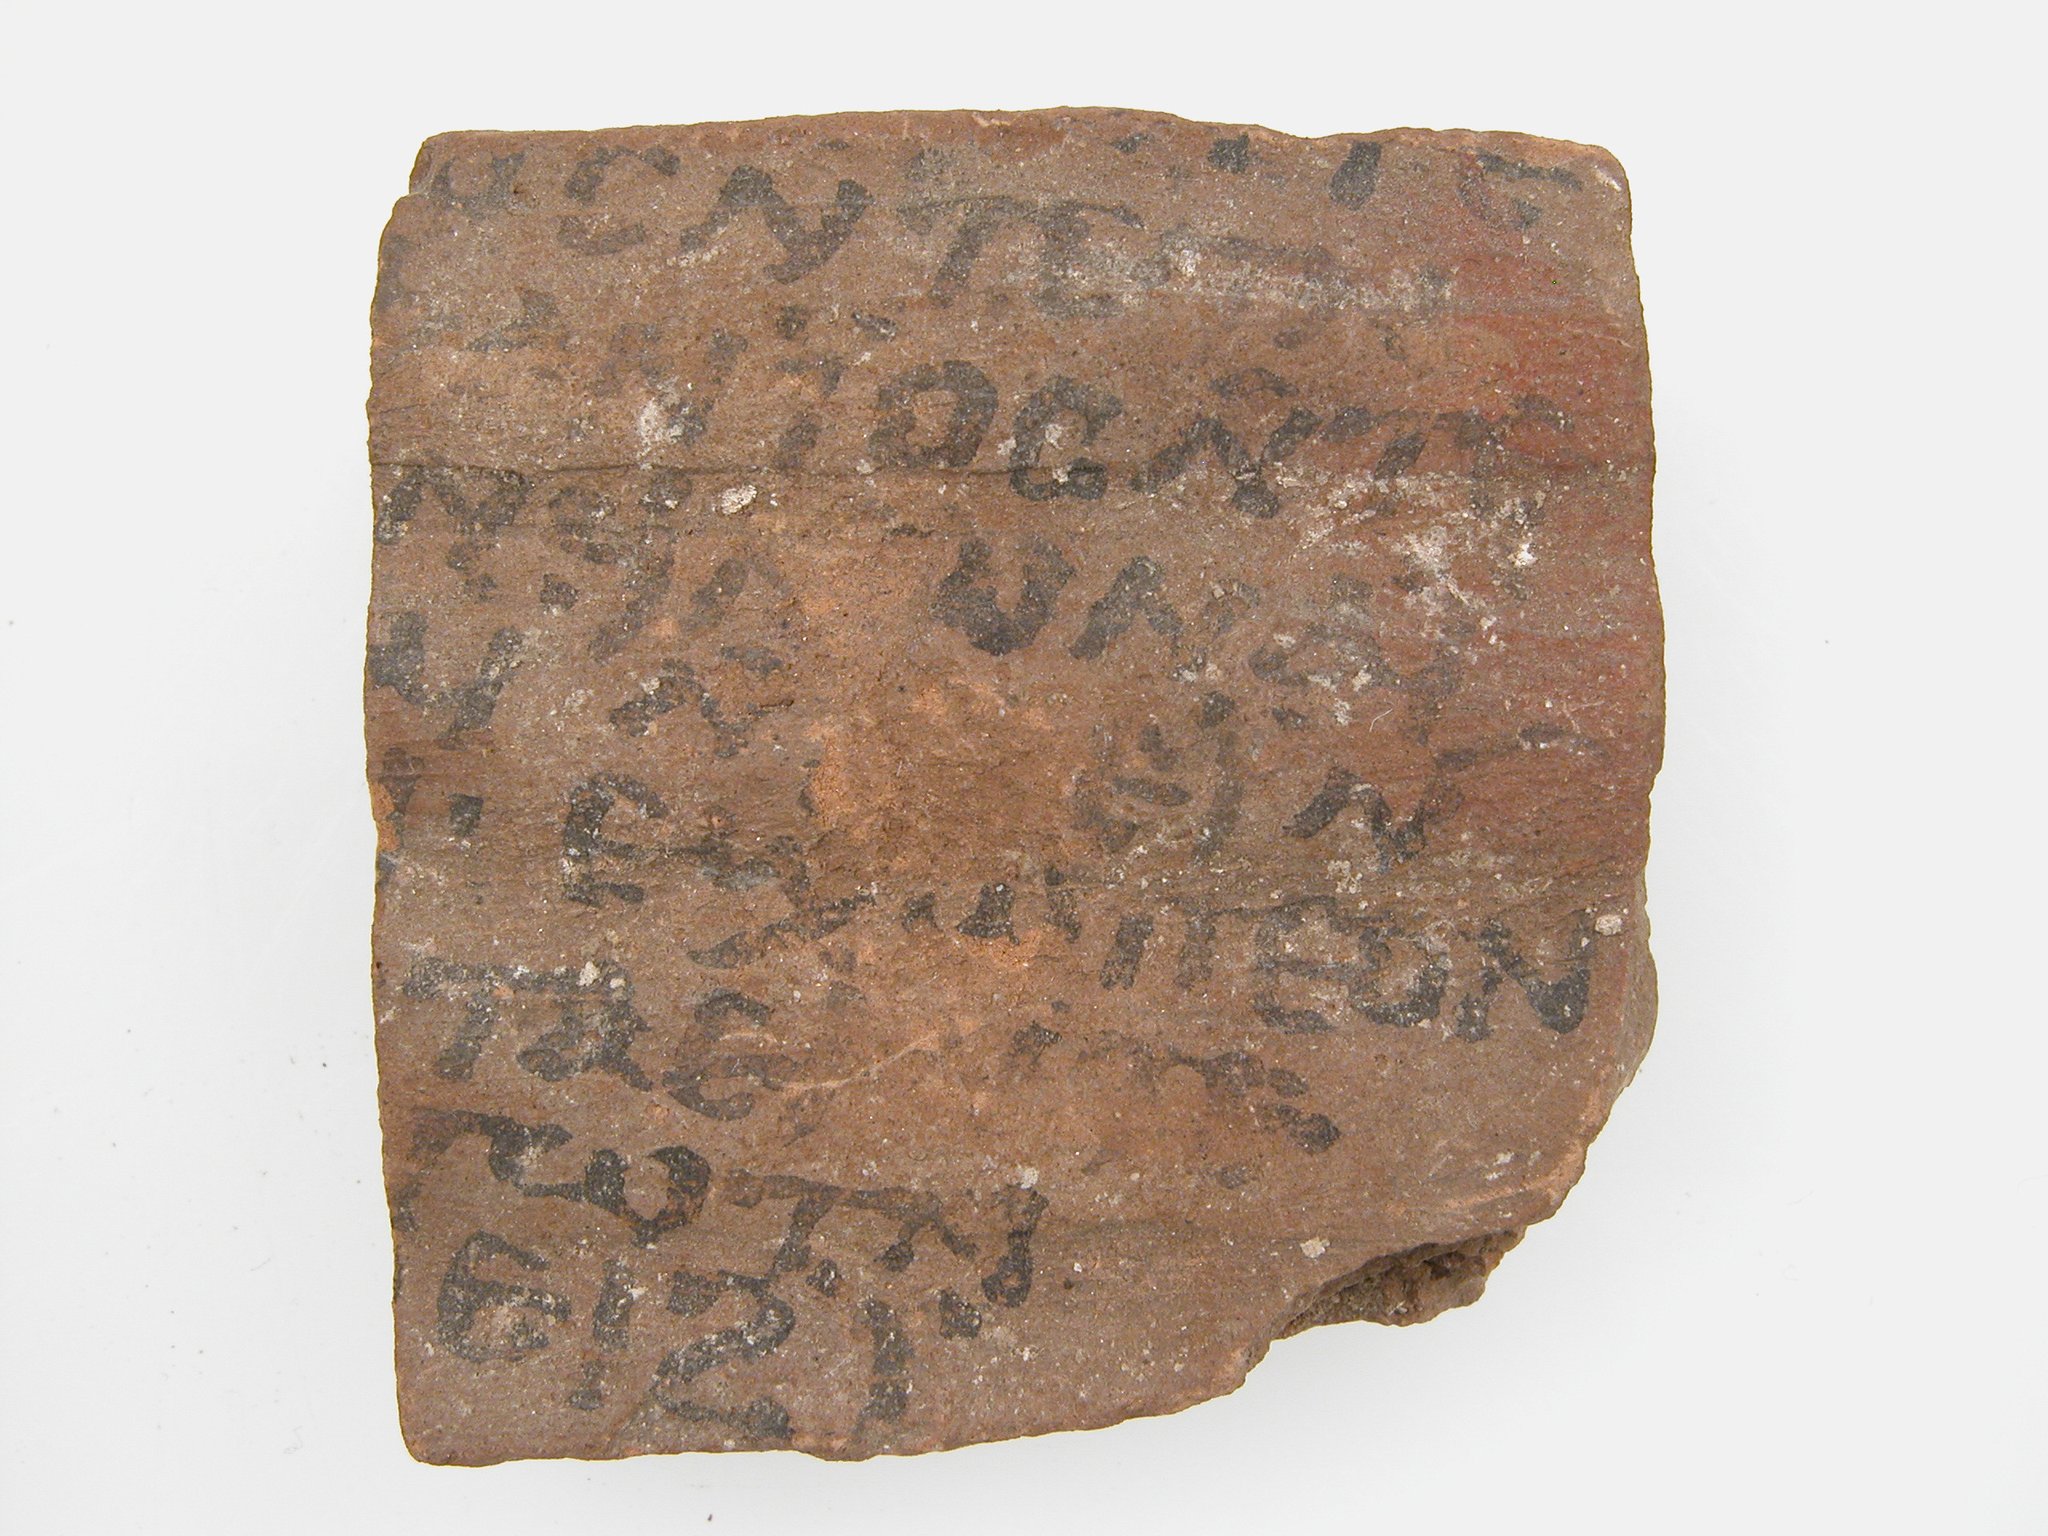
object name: ostrakon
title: Ostrakon with a Letter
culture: coptic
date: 600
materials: ink, pottery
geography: egypt